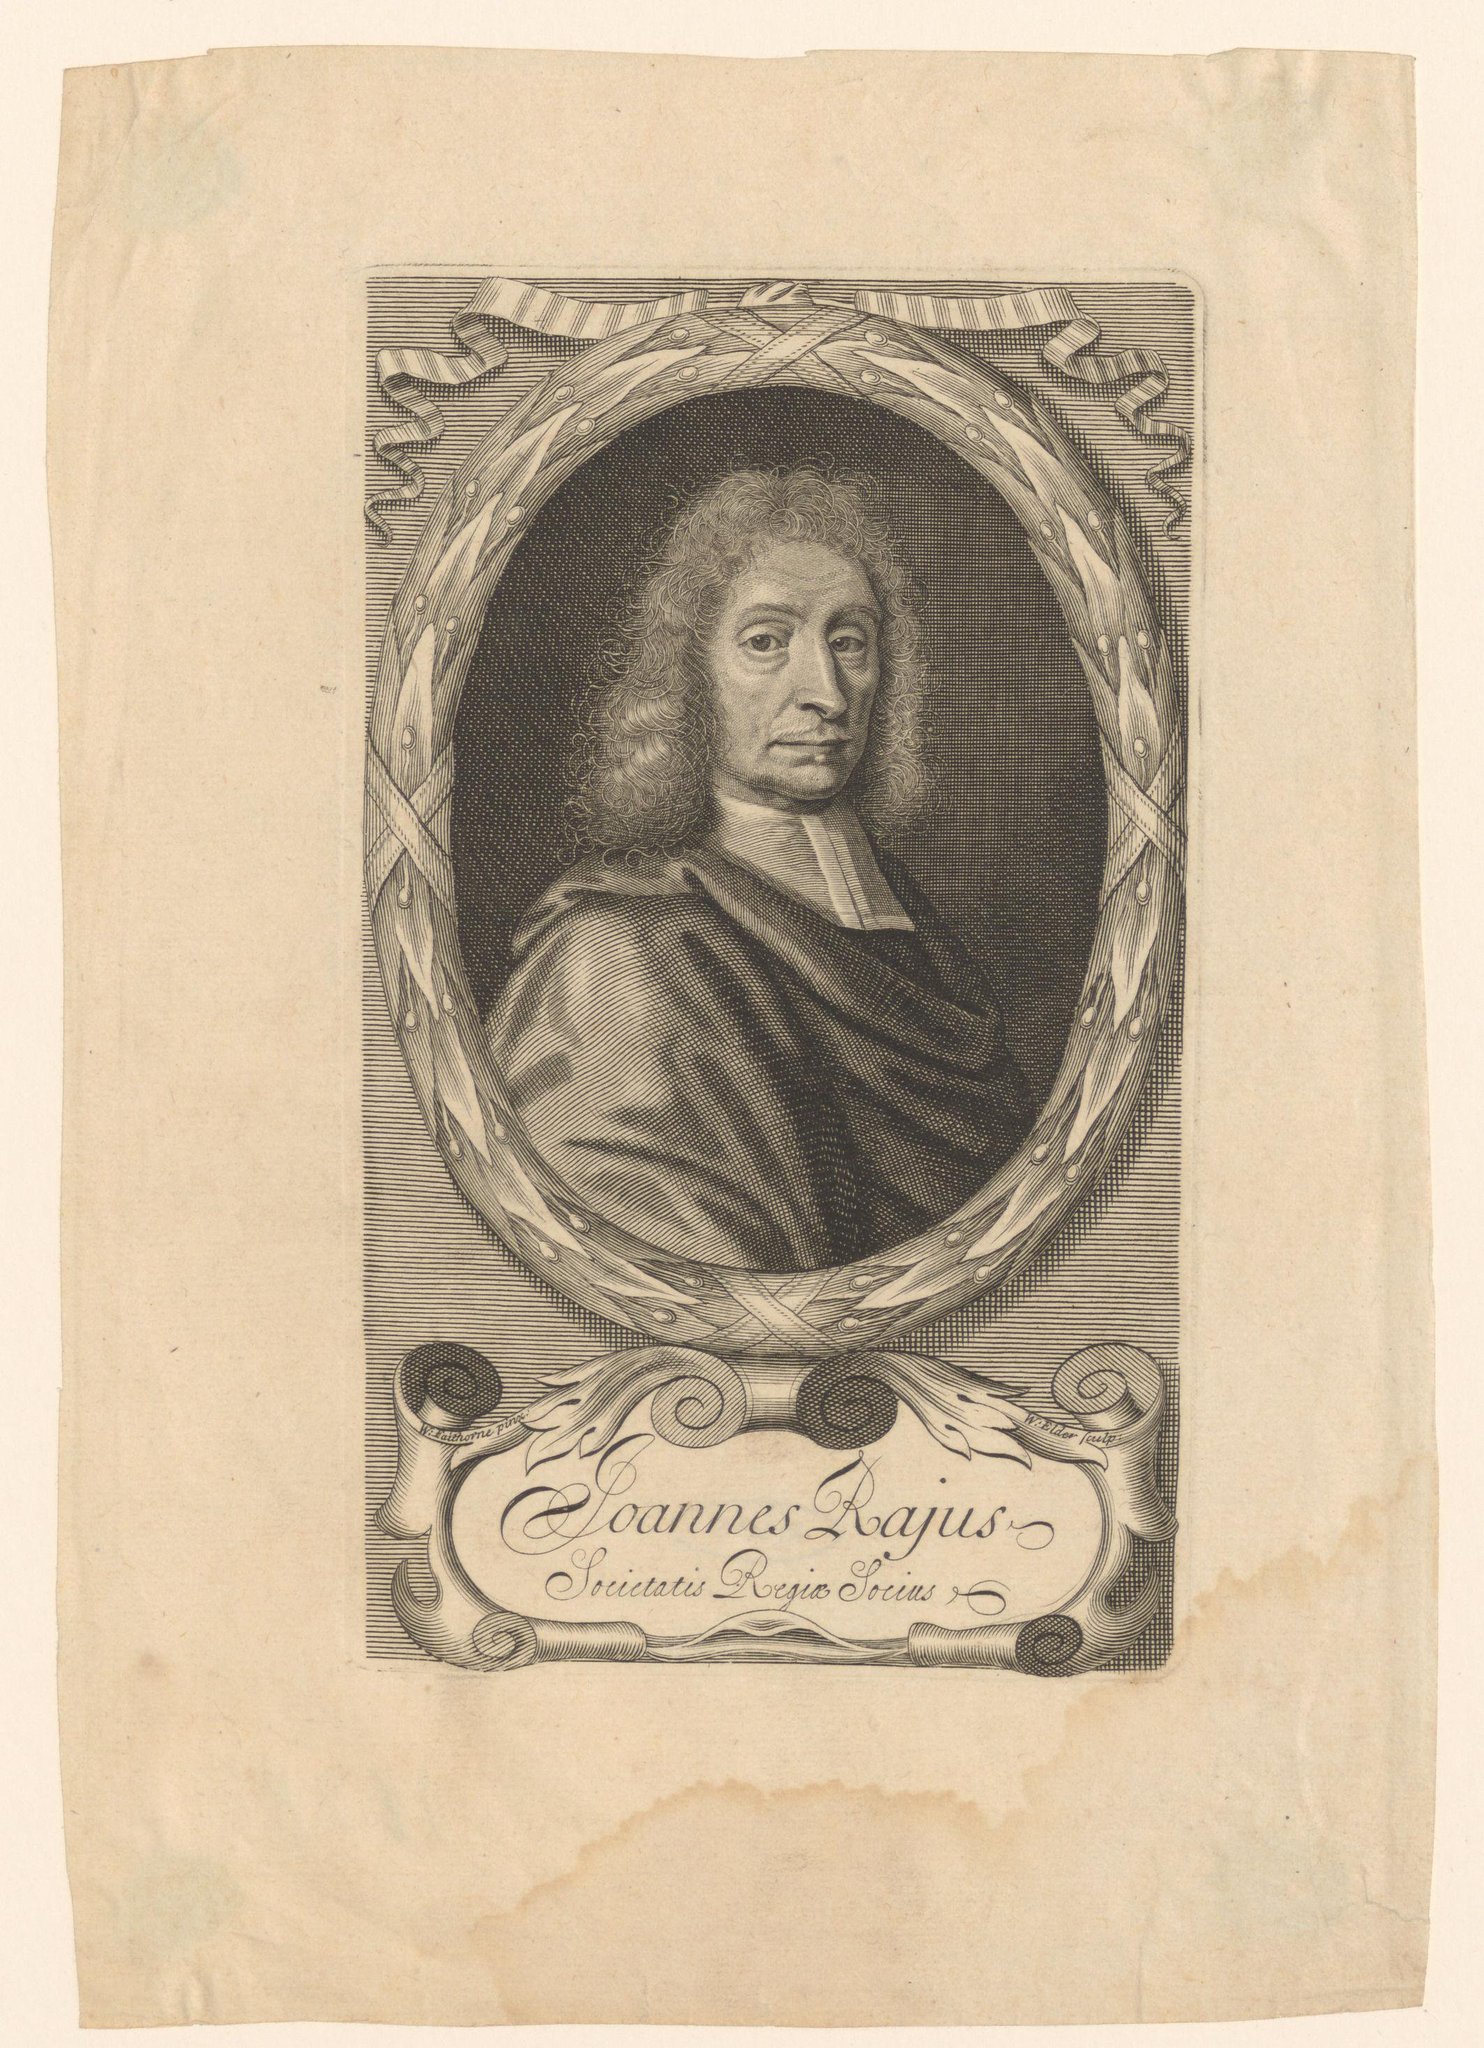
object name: print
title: Portret van John Ray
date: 1694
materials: paper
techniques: engraving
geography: london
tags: botany (+ portrait of scholar, scientist), historical persons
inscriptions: collector's mark: Lugt 2228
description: Prent ook gebruikt in: Ray, John. Stirpium Europaearum (...). Londen: Samuel Smith en Benjamin Walford, 1694. Prent is later gebruikt in publicaties uit 1701 en 1732.